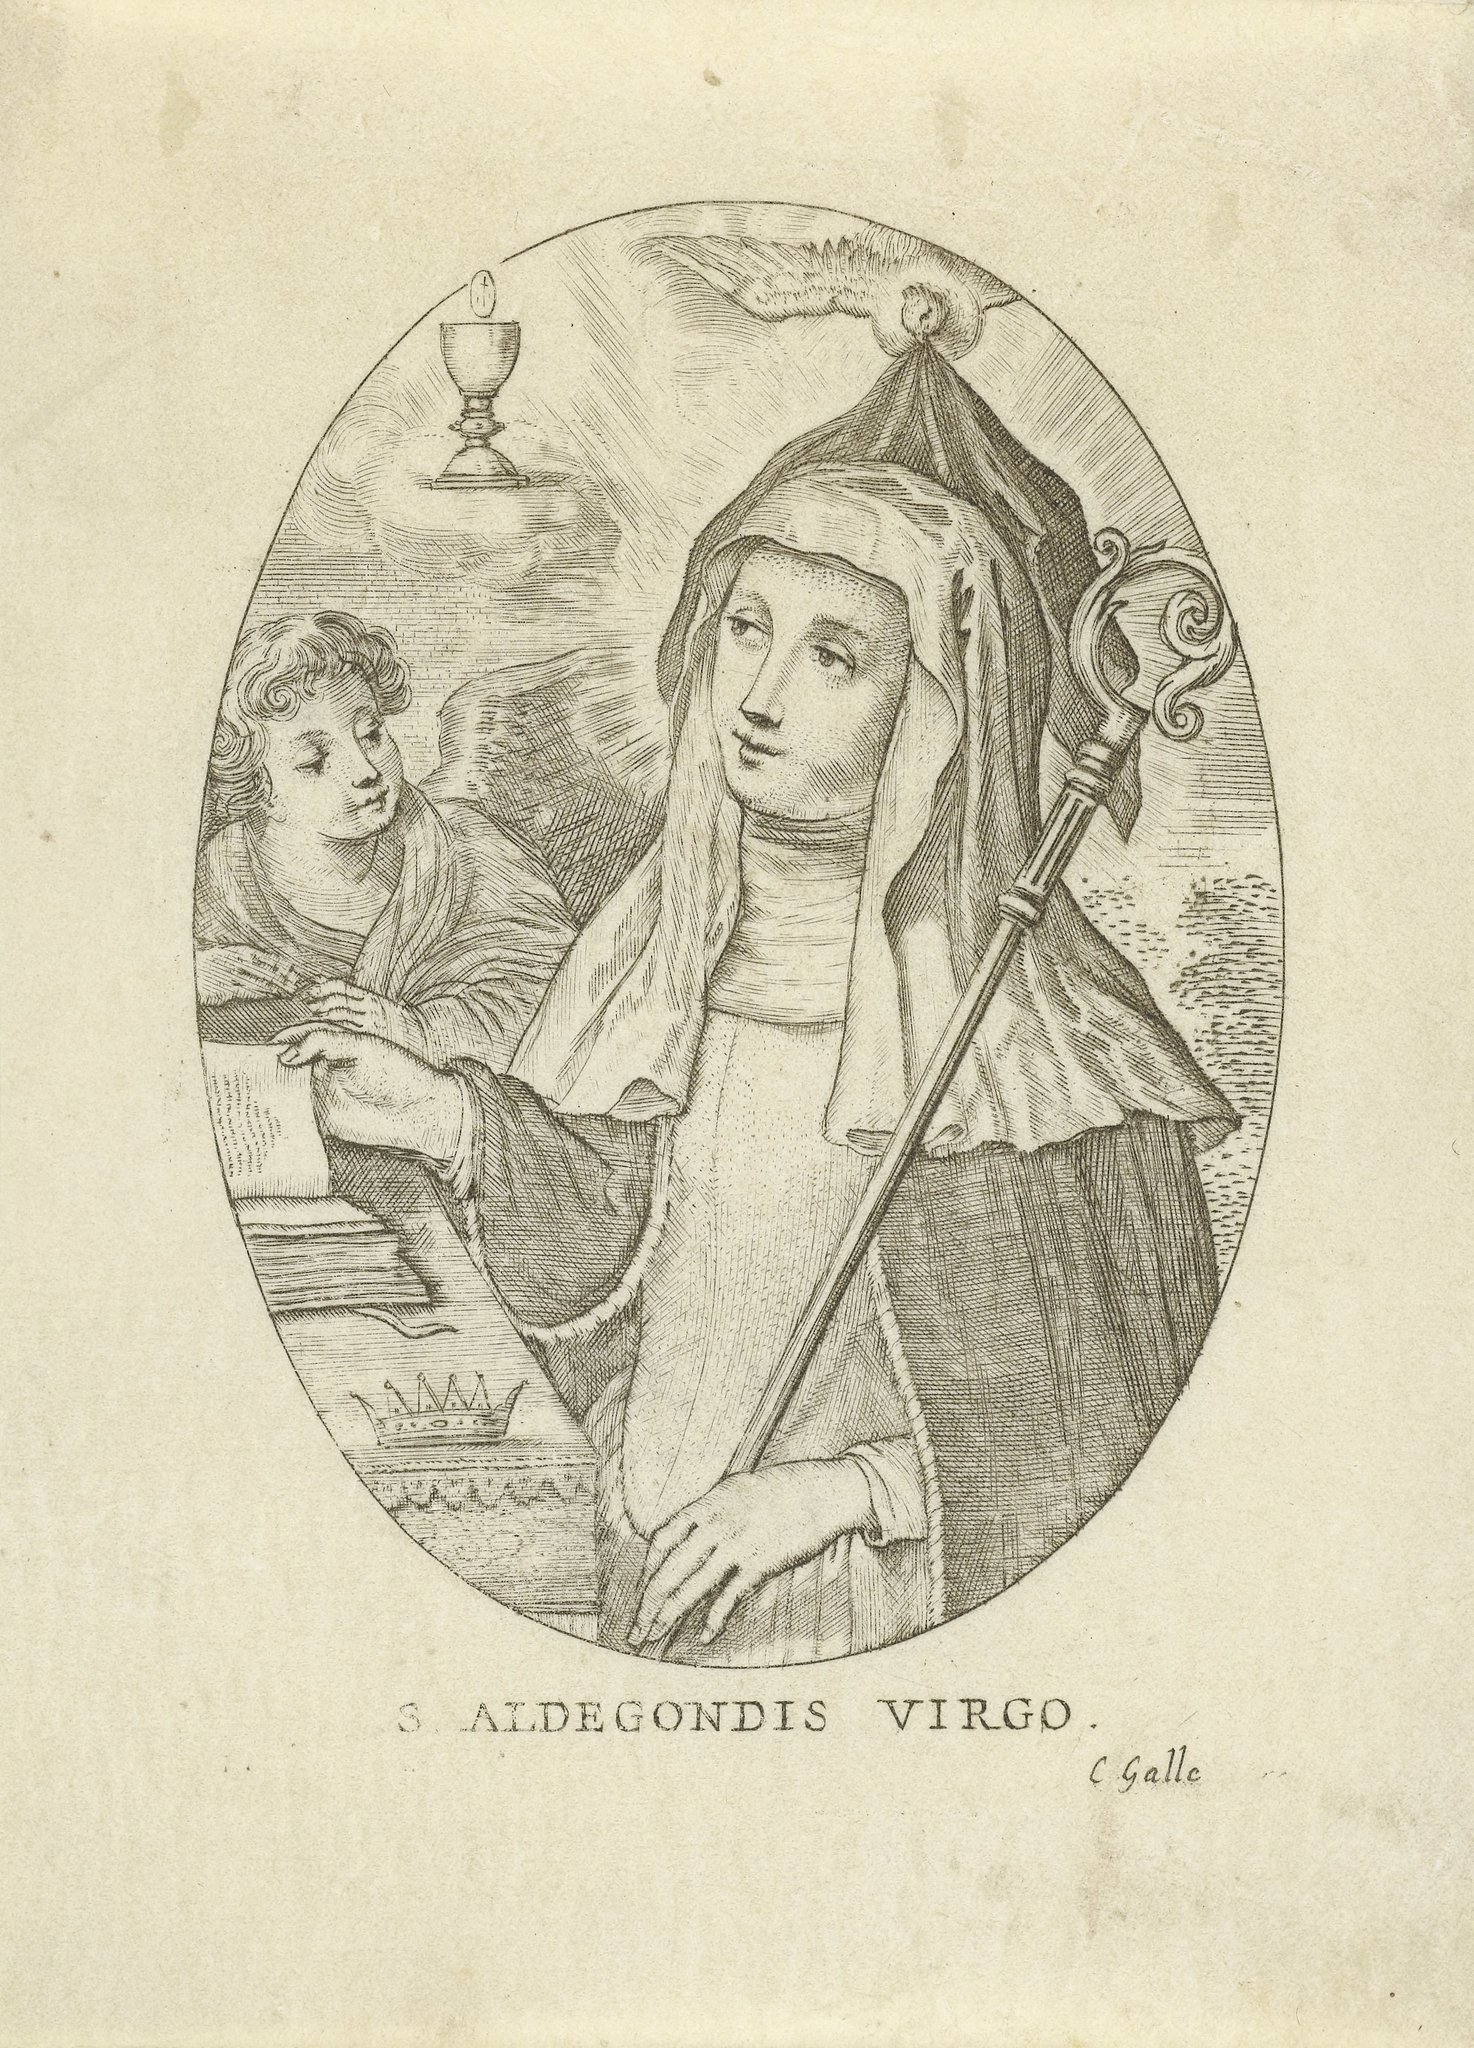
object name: print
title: H. Aldegondis van Maubeuge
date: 1638-1678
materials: parchment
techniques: engraving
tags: henegouwen, female saints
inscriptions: collector's mark: Lugt 2228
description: De heilige Aldegondis lezend in een boek. Een duif legt haar een zwarte sluier op het hoofd. In haar linker hand houdt zij een staf. Naast haar aan tafel staat een engel. Boven de engel zweeft een kelk met een hostie.